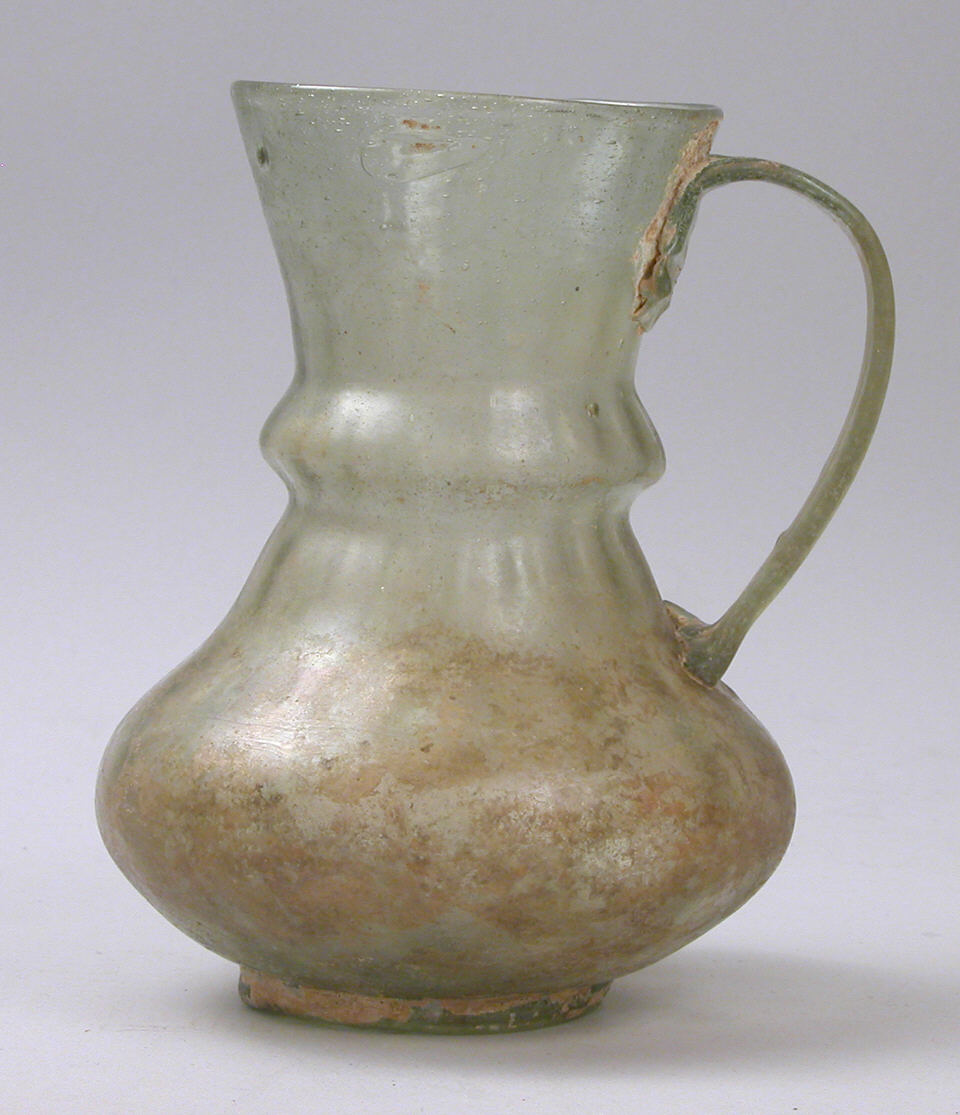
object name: ewer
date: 1101-1300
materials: glass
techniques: glassblowing, tooling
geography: syria